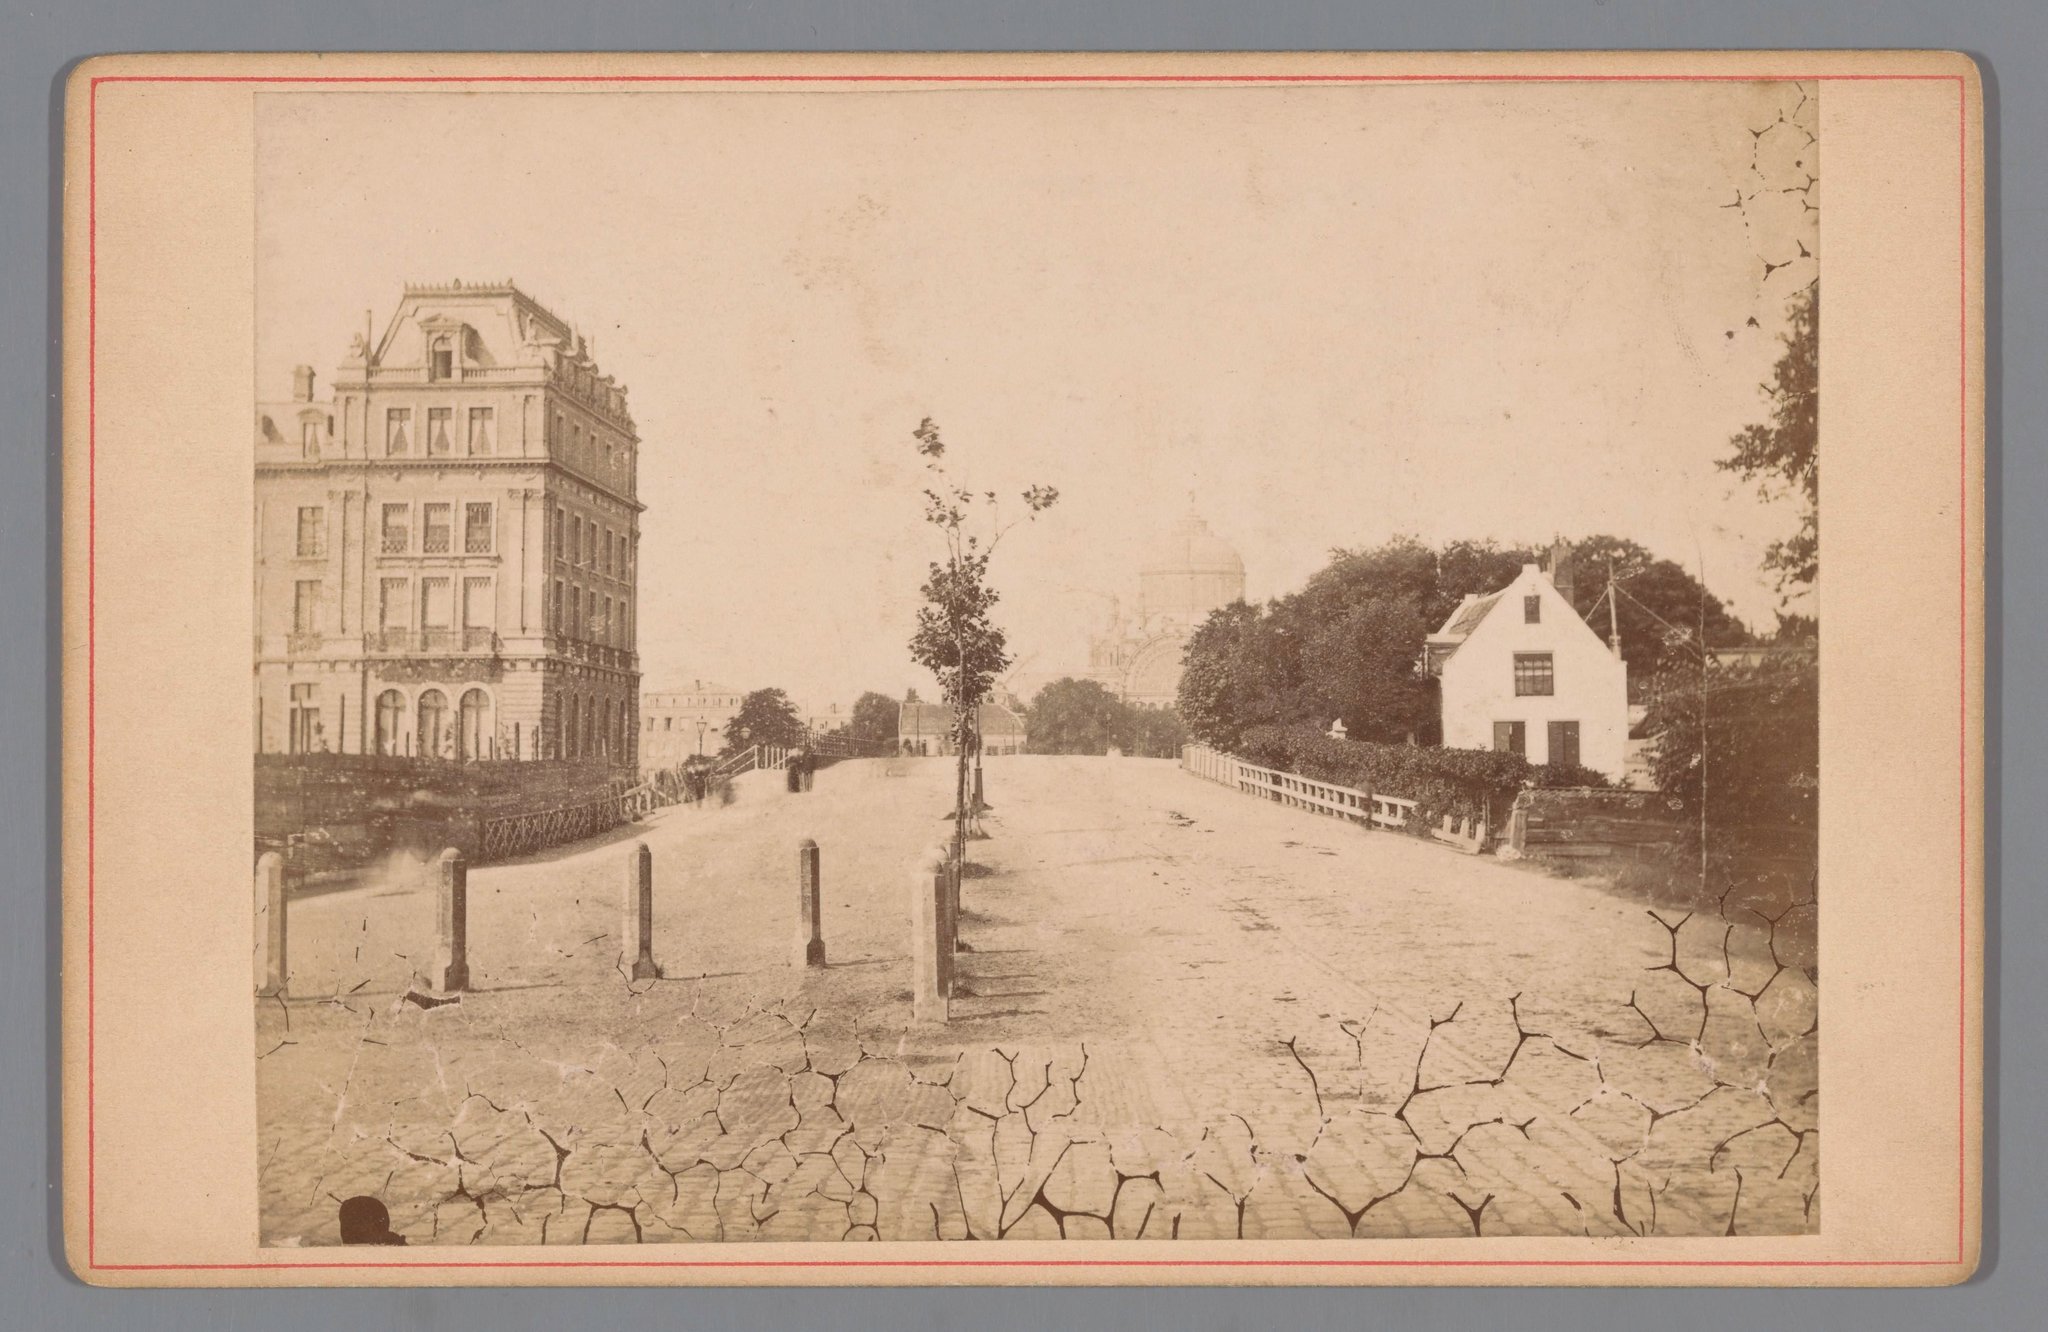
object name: cabinet photograph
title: Gezicht op Hoogesluis vanaf Sarphatistraat te Amsterdam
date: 1850-1900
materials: cardboard, photographic support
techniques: albumen print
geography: amsterdam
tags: city-view in general; 'veduta'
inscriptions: retailer's mark: ‘Inrichting voor Photografie./ VAN/ P.H.J. REYNET DE LA RUE,/ Muziek-, Boek, Photografie, Papierhandel enz./ Utrechtschestraat 35. Amsterdam/ Photografeert Gebouwen, Groepen,/ Portretten enz. (bij ieder aan huis), zoowel binnen/ als buiten Amsterdam. Maakt VERGOOTINGEN en COPIËN/ van Photografiën, Teekeningen, Gravures, Schilderijen enz./ Verkleiningen van af 25 stuks voor 60 Ct.’, inscription: ‘Sarphatistraat, links Amstelhotel, midden/ Hoogesluis/ foto na 1868 (molen de Leeuw [...] afgebroken)’